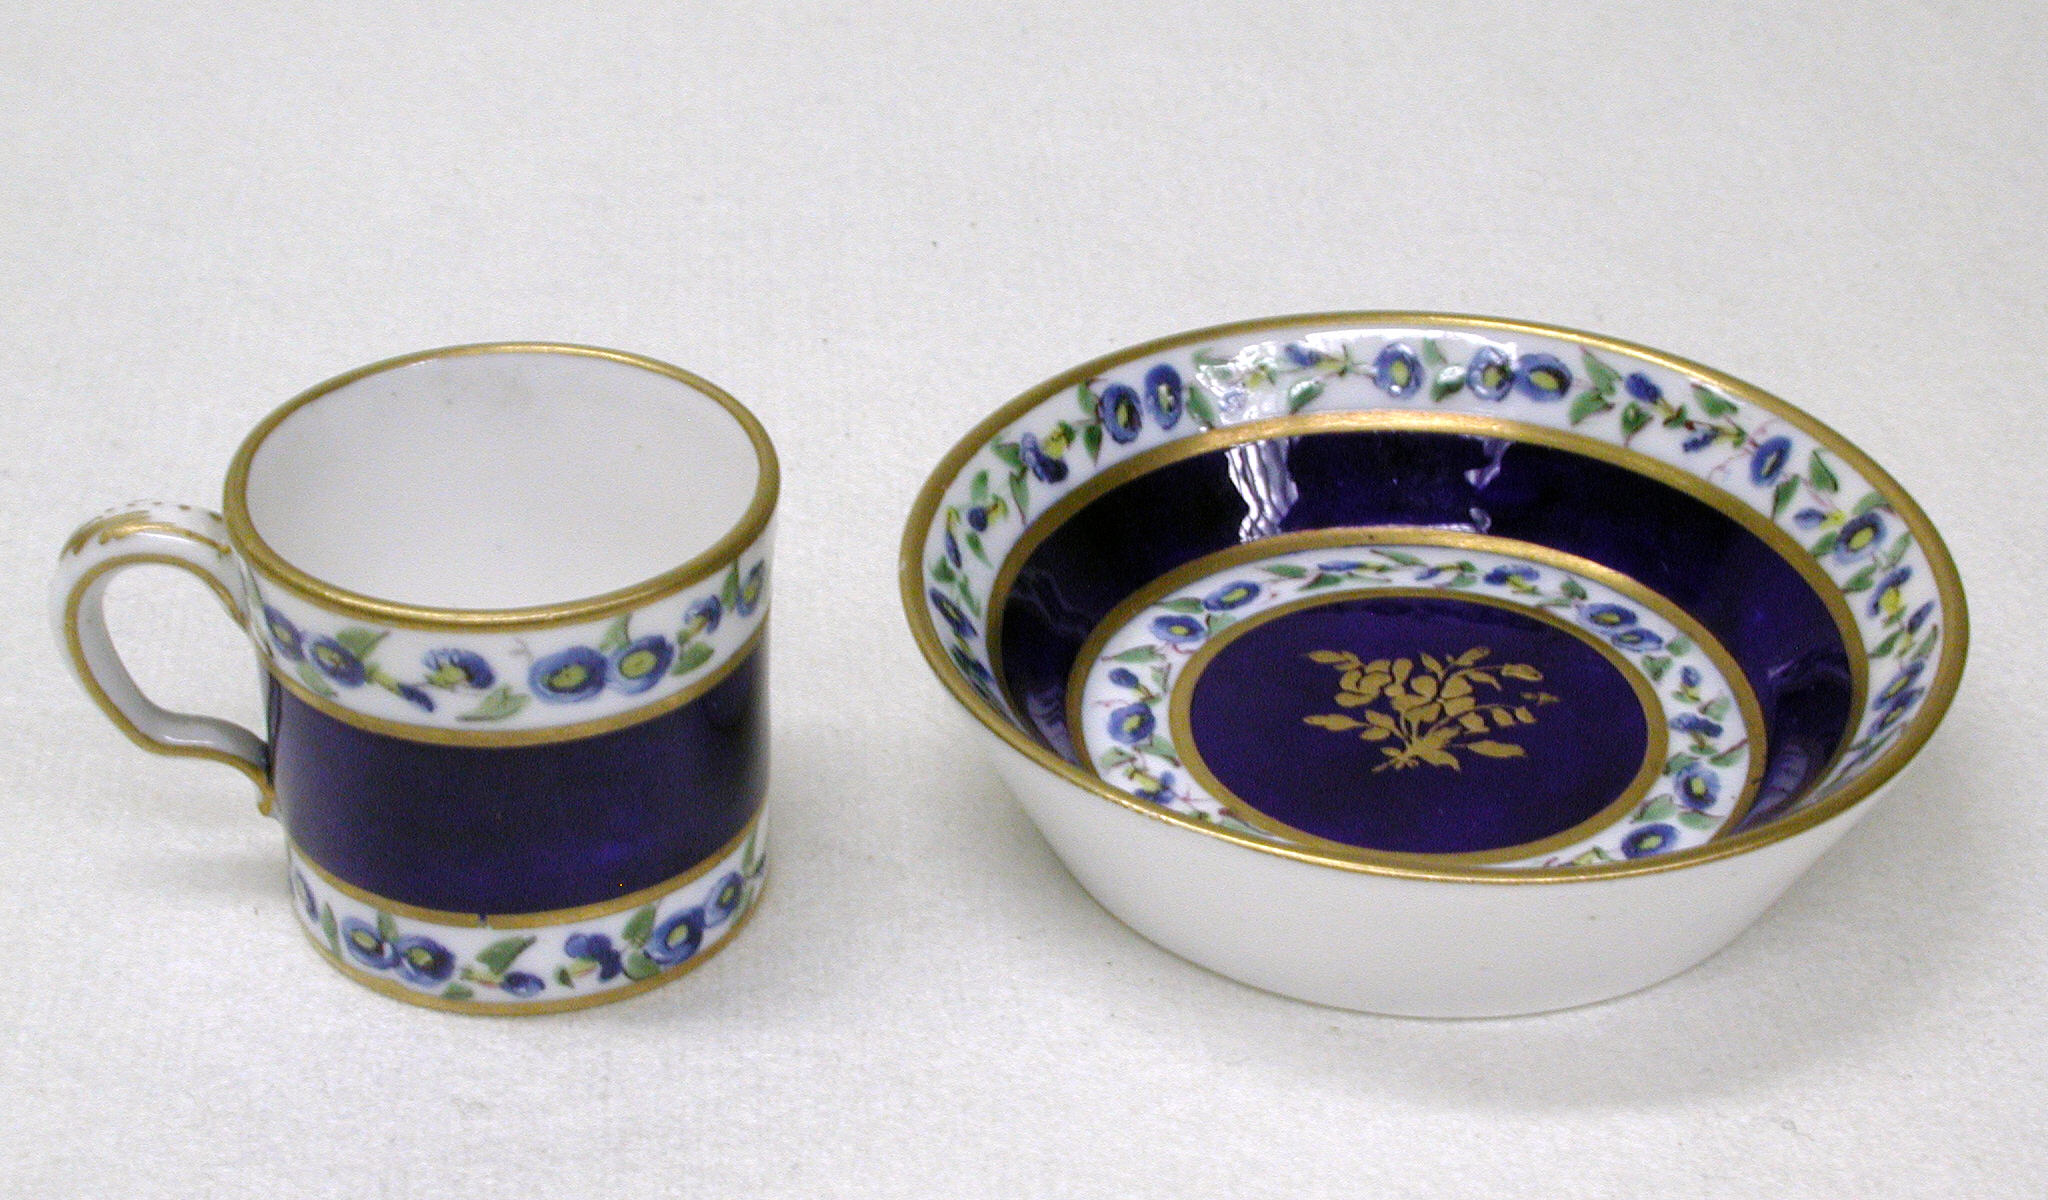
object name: cup and saucer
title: Miniature cup and saucer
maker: sèvres manufactory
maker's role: manufactory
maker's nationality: french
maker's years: 1740-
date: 1782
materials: soft paste porcelain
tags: flowers